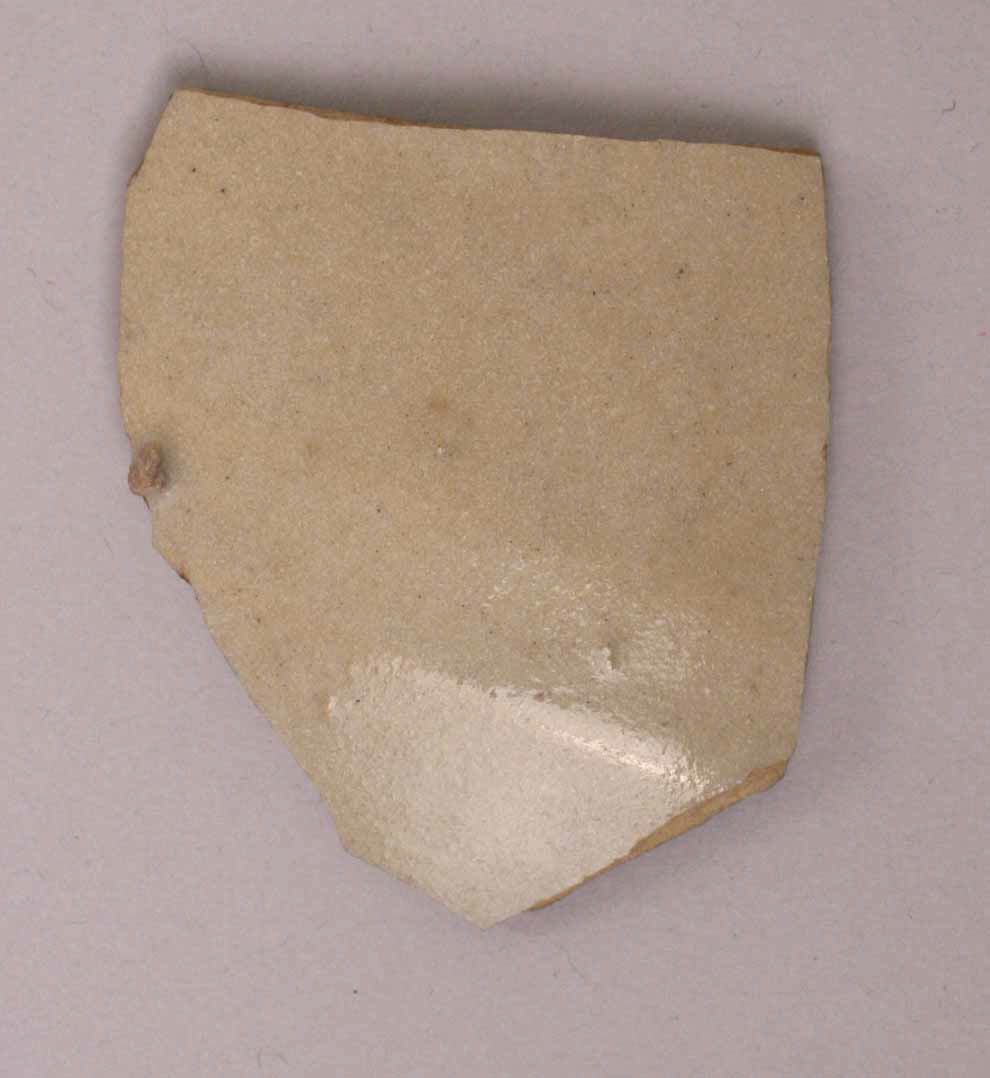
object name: fragment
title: Glazed Ceramic Fragments: Splashed, Opacified White, and Green Glazed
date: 801-900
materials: earthenware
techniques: glazing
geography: iraq